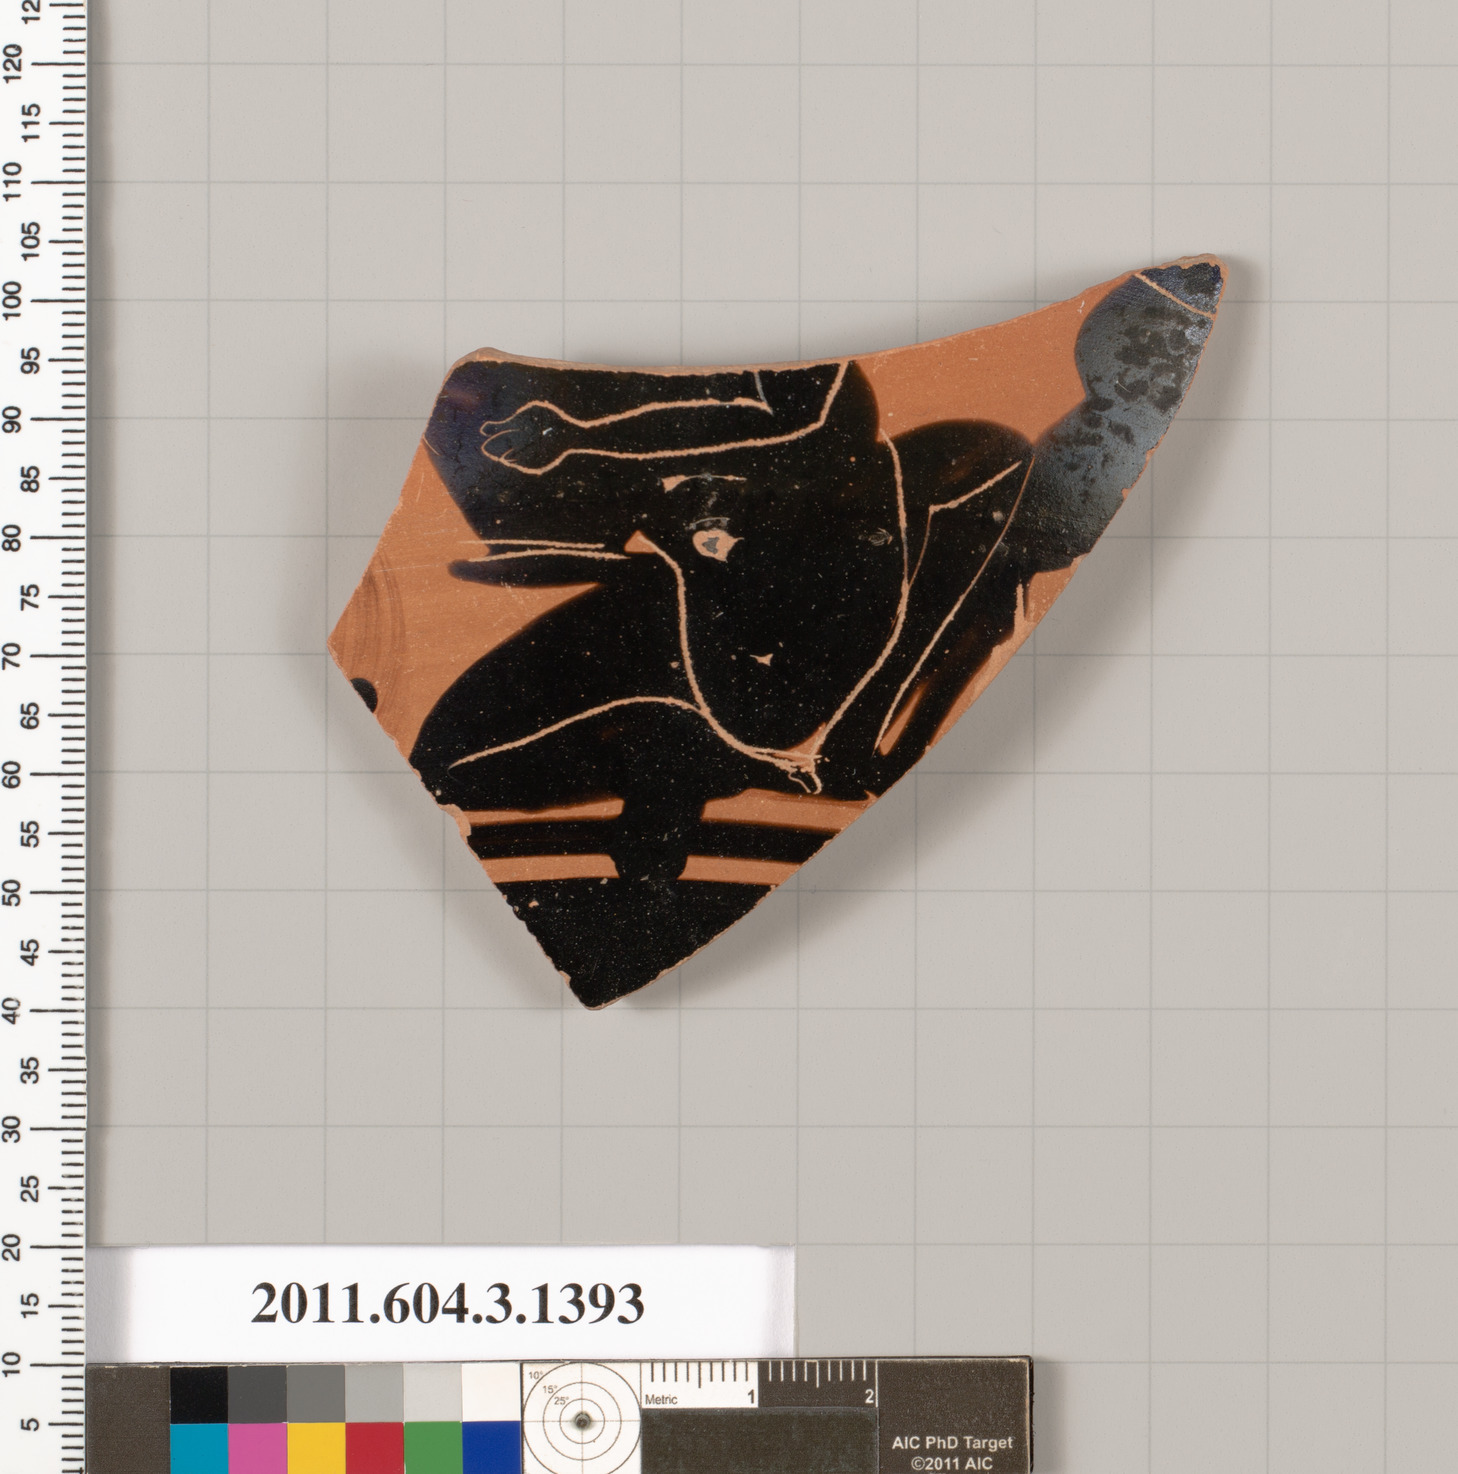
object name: skyphos fragment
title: Terracotta fragment of a skyphos (deep drinking cup)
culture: greek, attic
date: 534-501 BCE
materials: terracotta